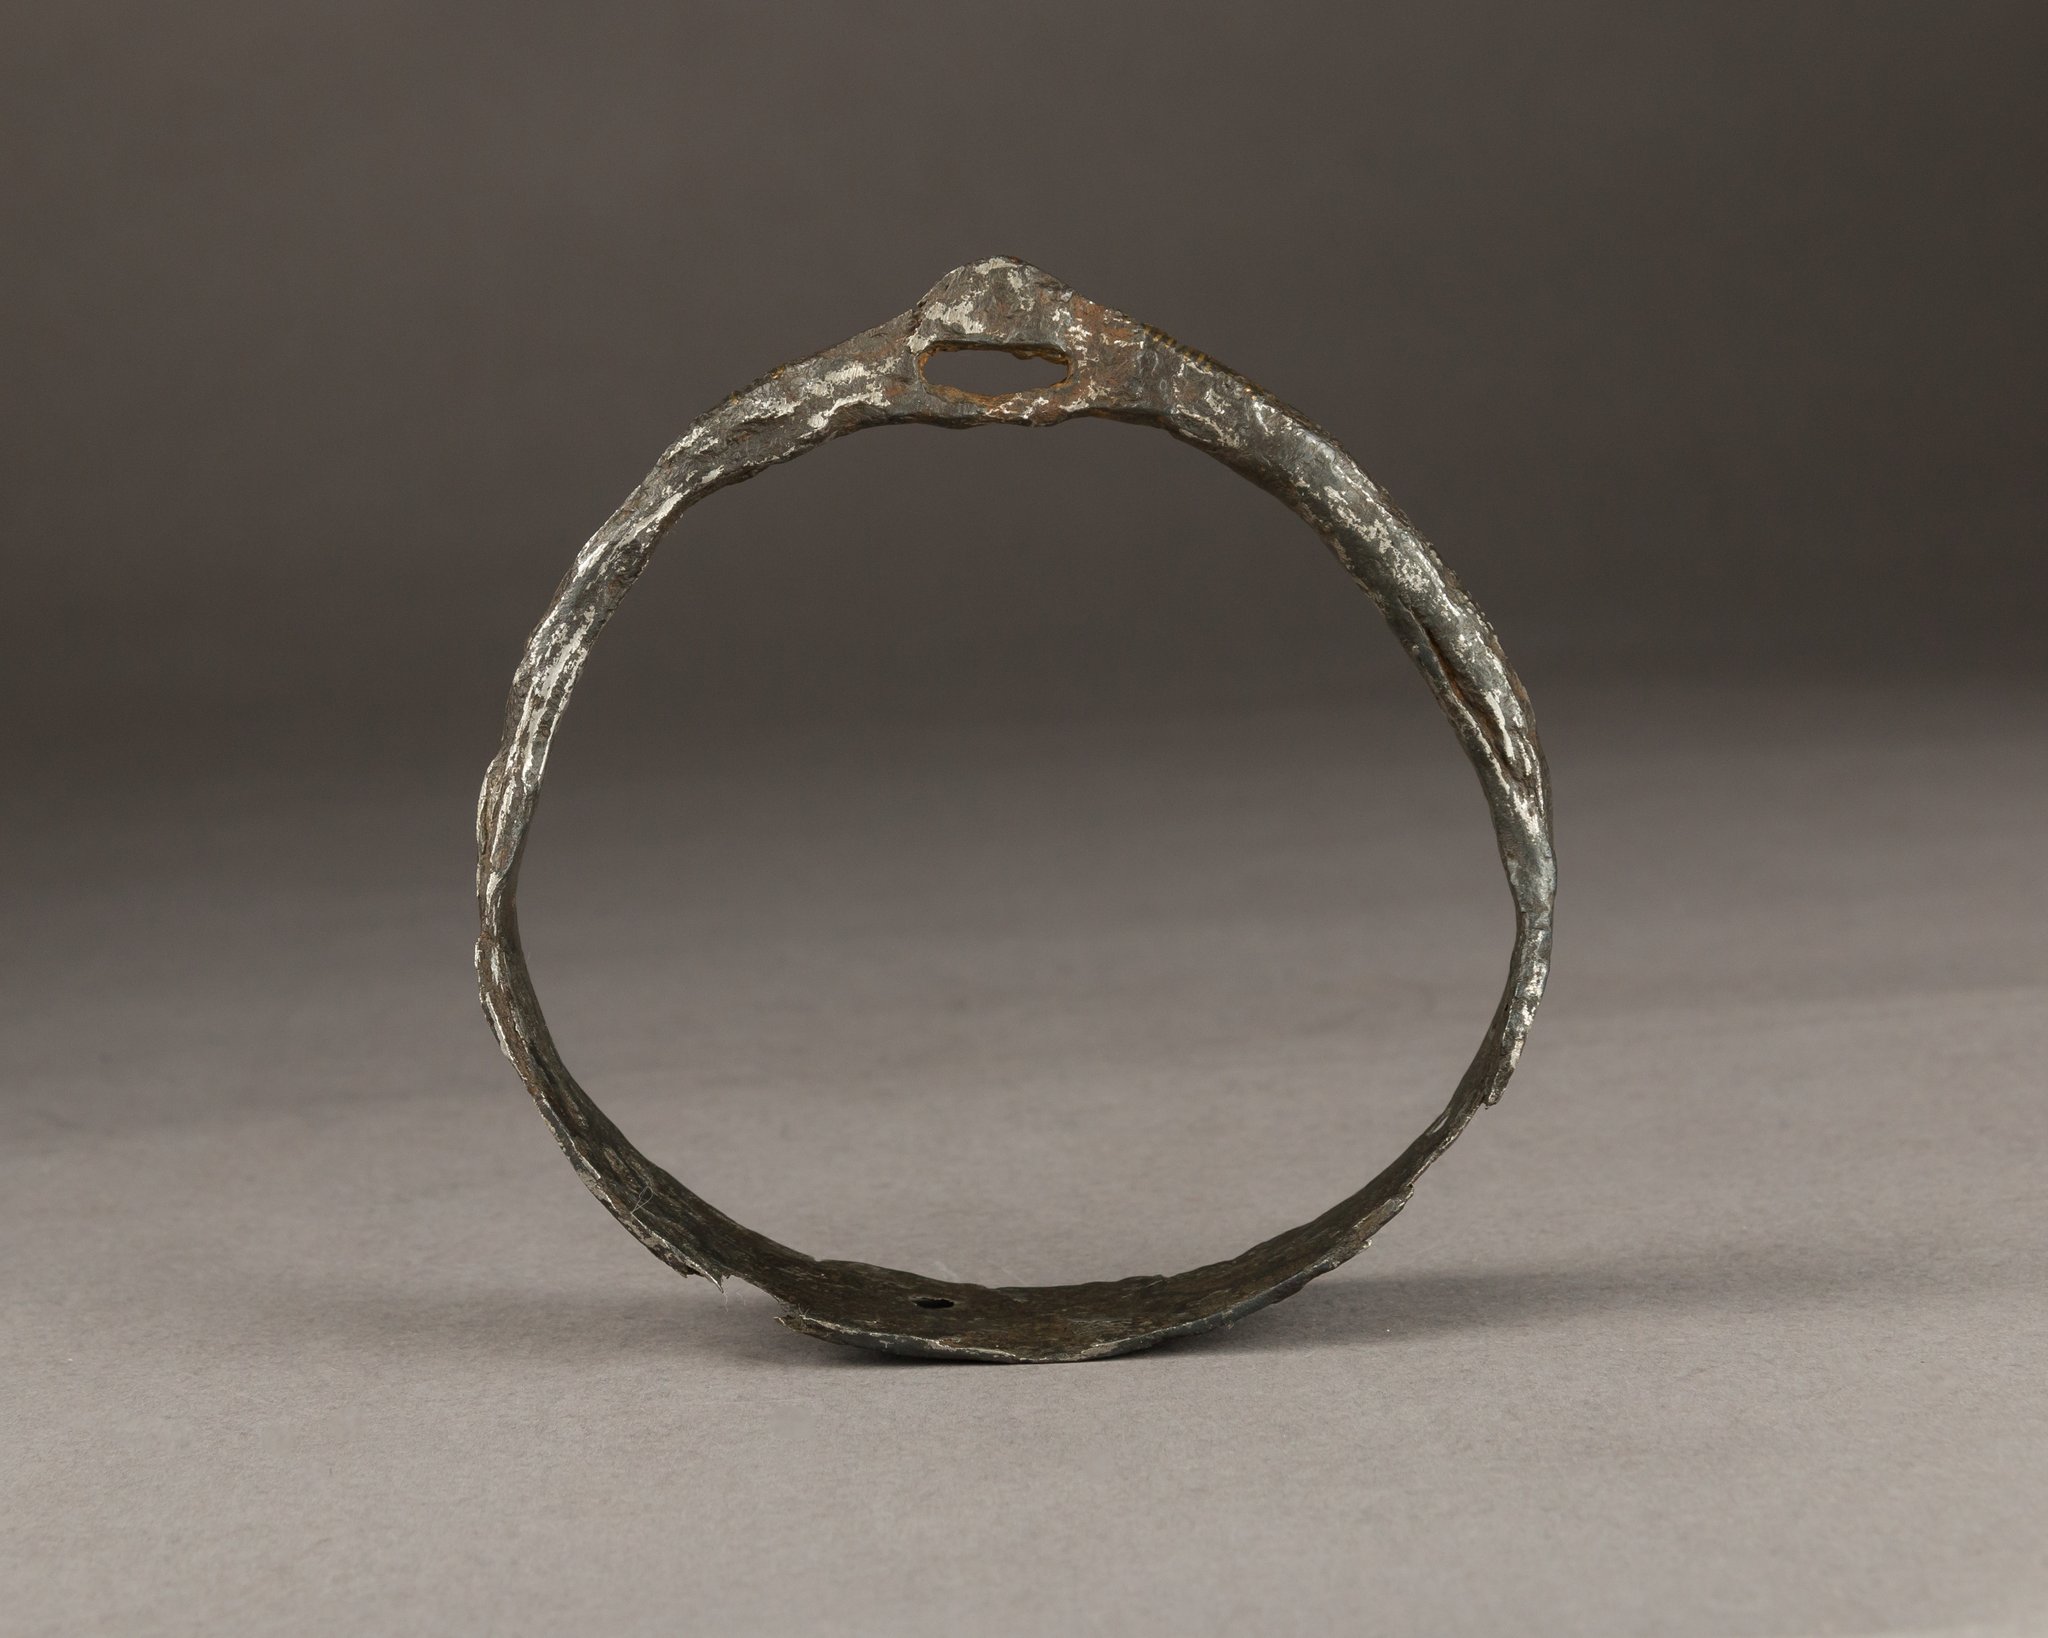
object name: stirrup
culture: west slavic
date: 1101-1300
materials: copper alloy, iron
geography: poland